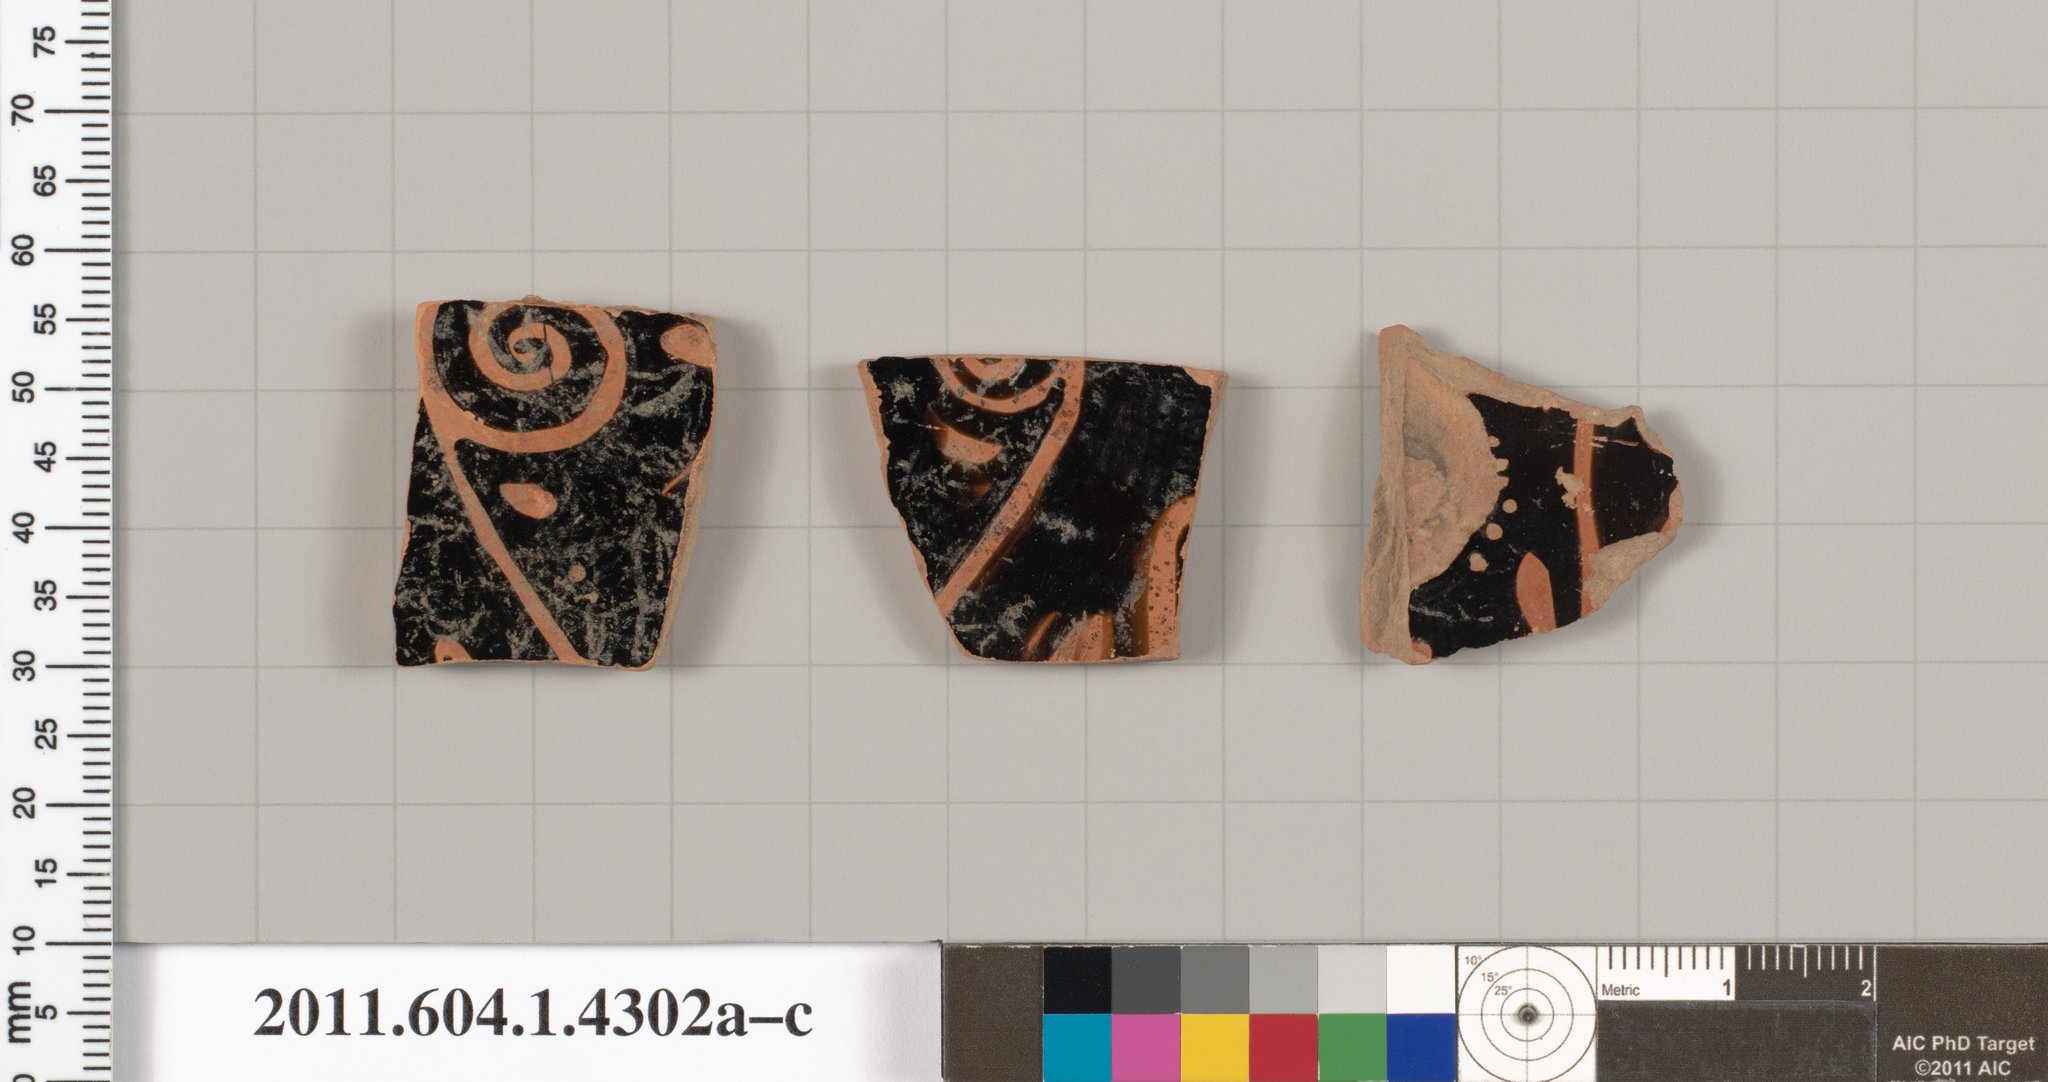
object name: kylix fragment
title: Terracotta fragments of kylikes (drinking cups)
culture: greek, attic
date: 500-451 BCE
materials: terracotta